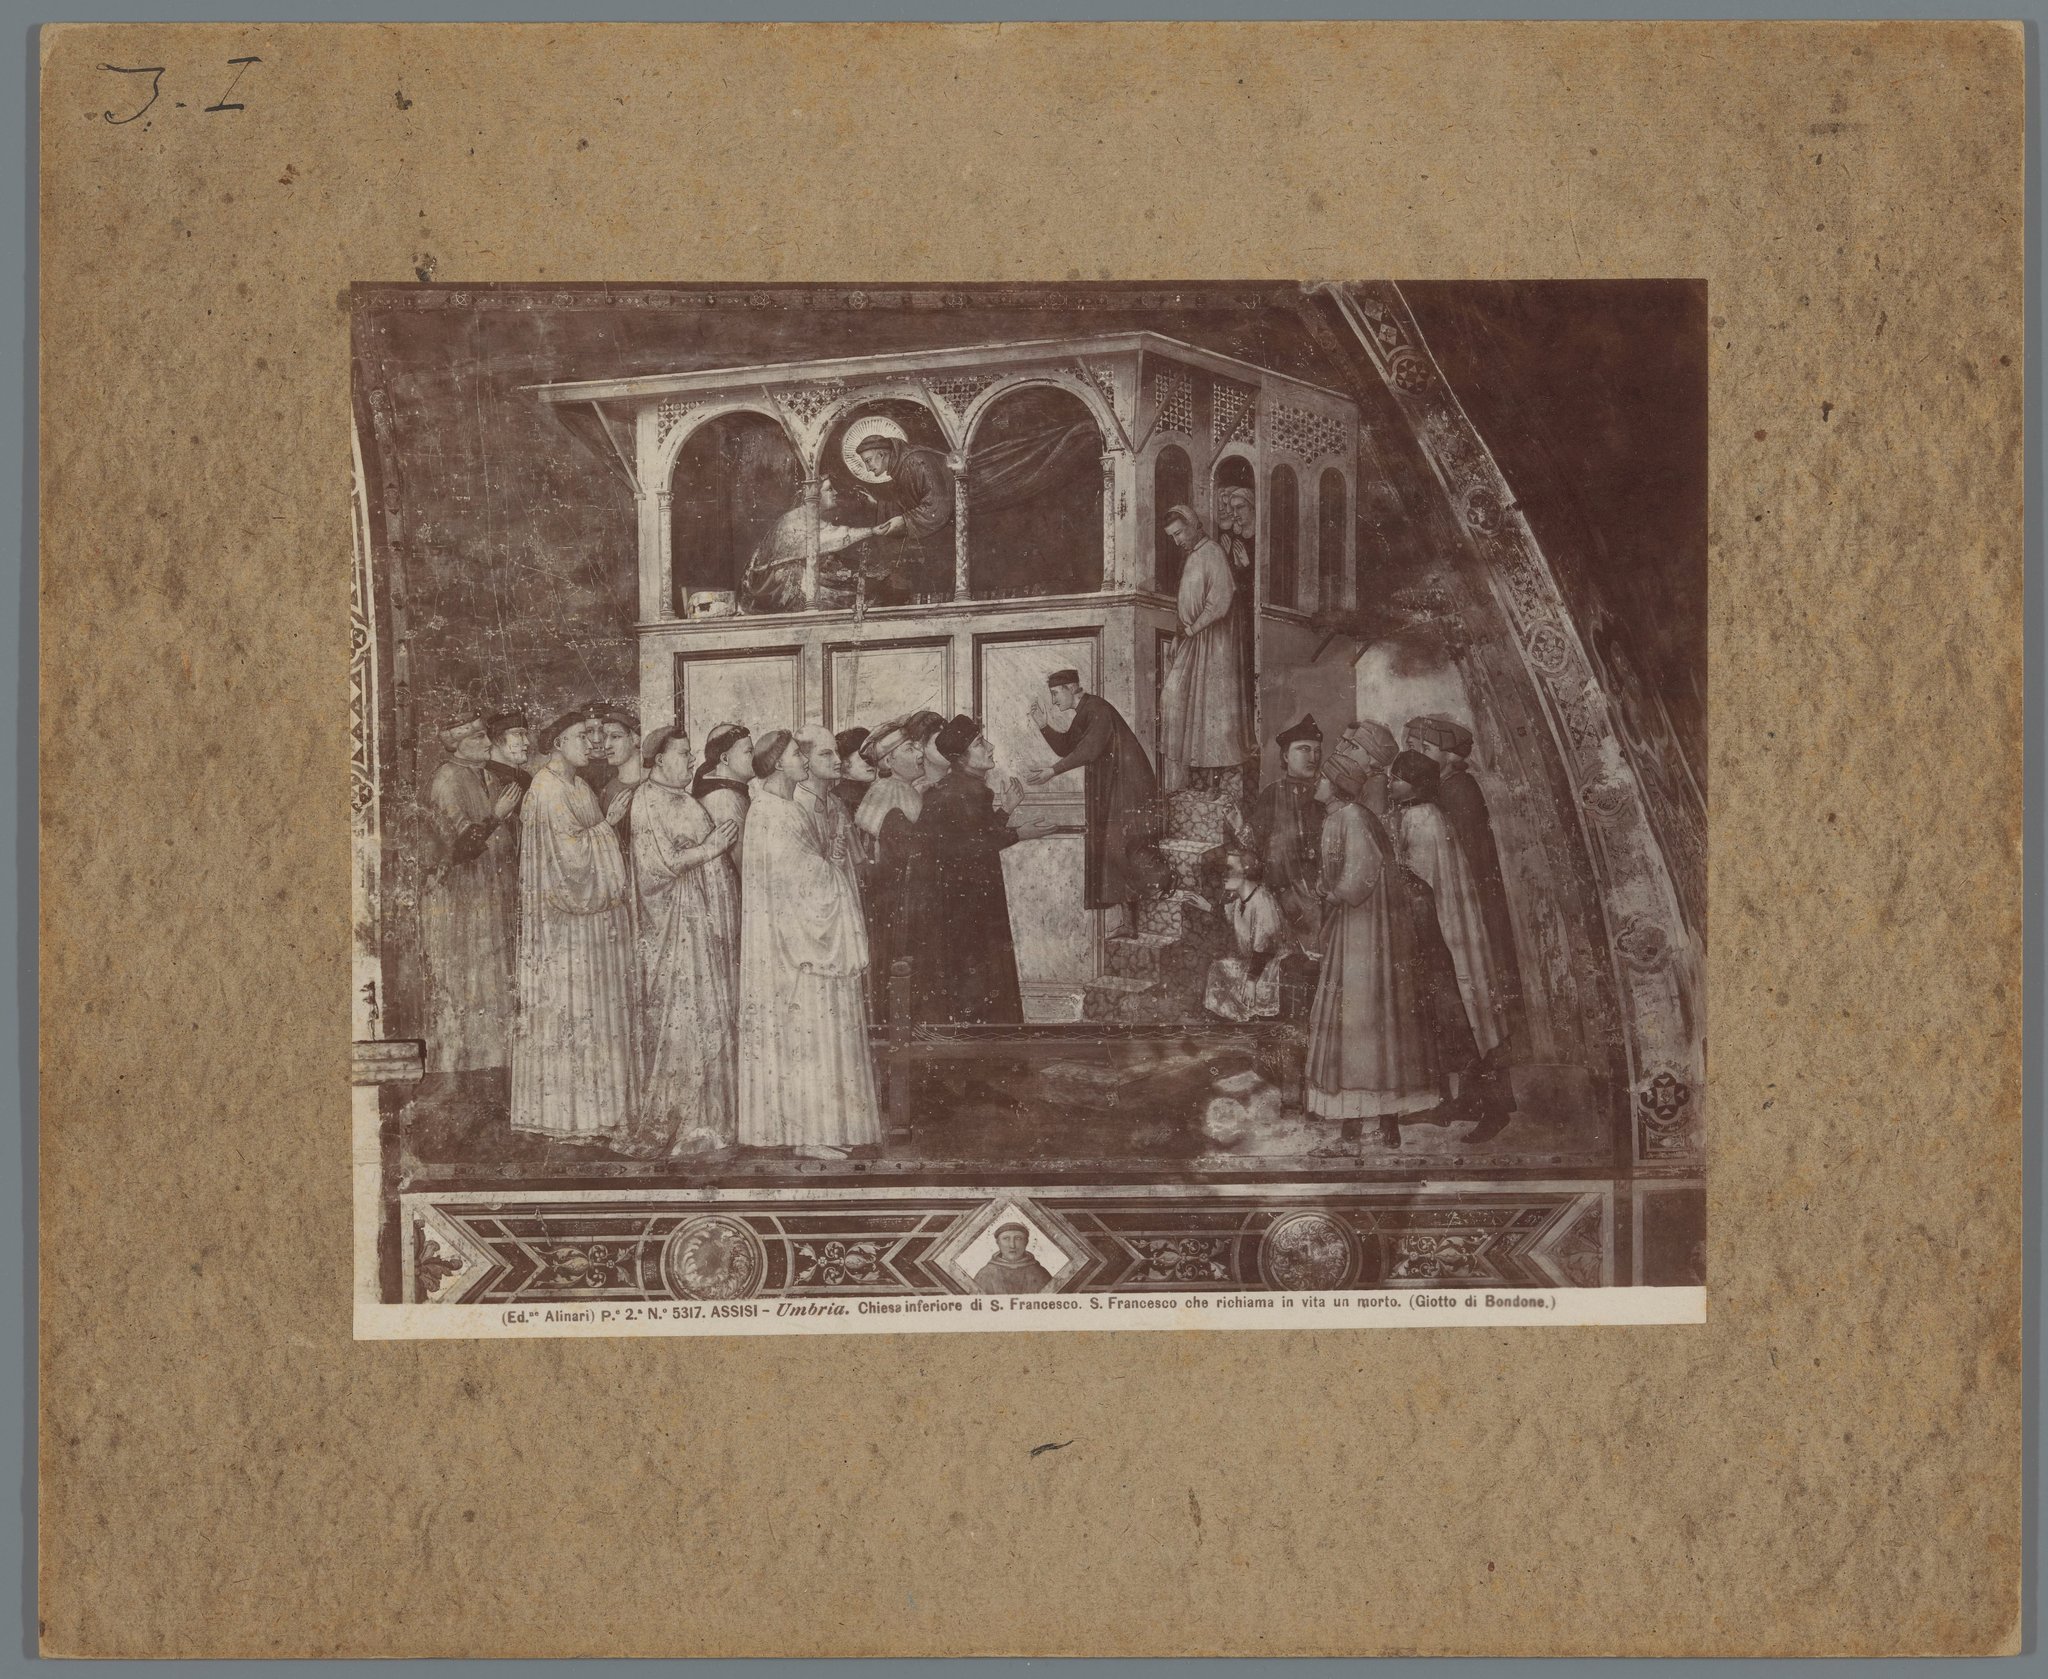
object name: photograph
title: Fotoreproductie van een fresco door Giotto, voorstellende de opwekking van een dode door de heilige Franciscus van Assisi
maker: giotto de bondone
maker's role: painter, sculptor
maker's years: 1266-1337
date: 1875-1900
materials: cardboard, photographic support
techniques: albumen print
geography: sint-franciscusbasiliek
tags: raising from the dead, miraculous activities and events ~ st. francis of assisi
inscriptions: number: ‘P.e 2.a N.o 5317.’, collector's mark: Lugt 3937